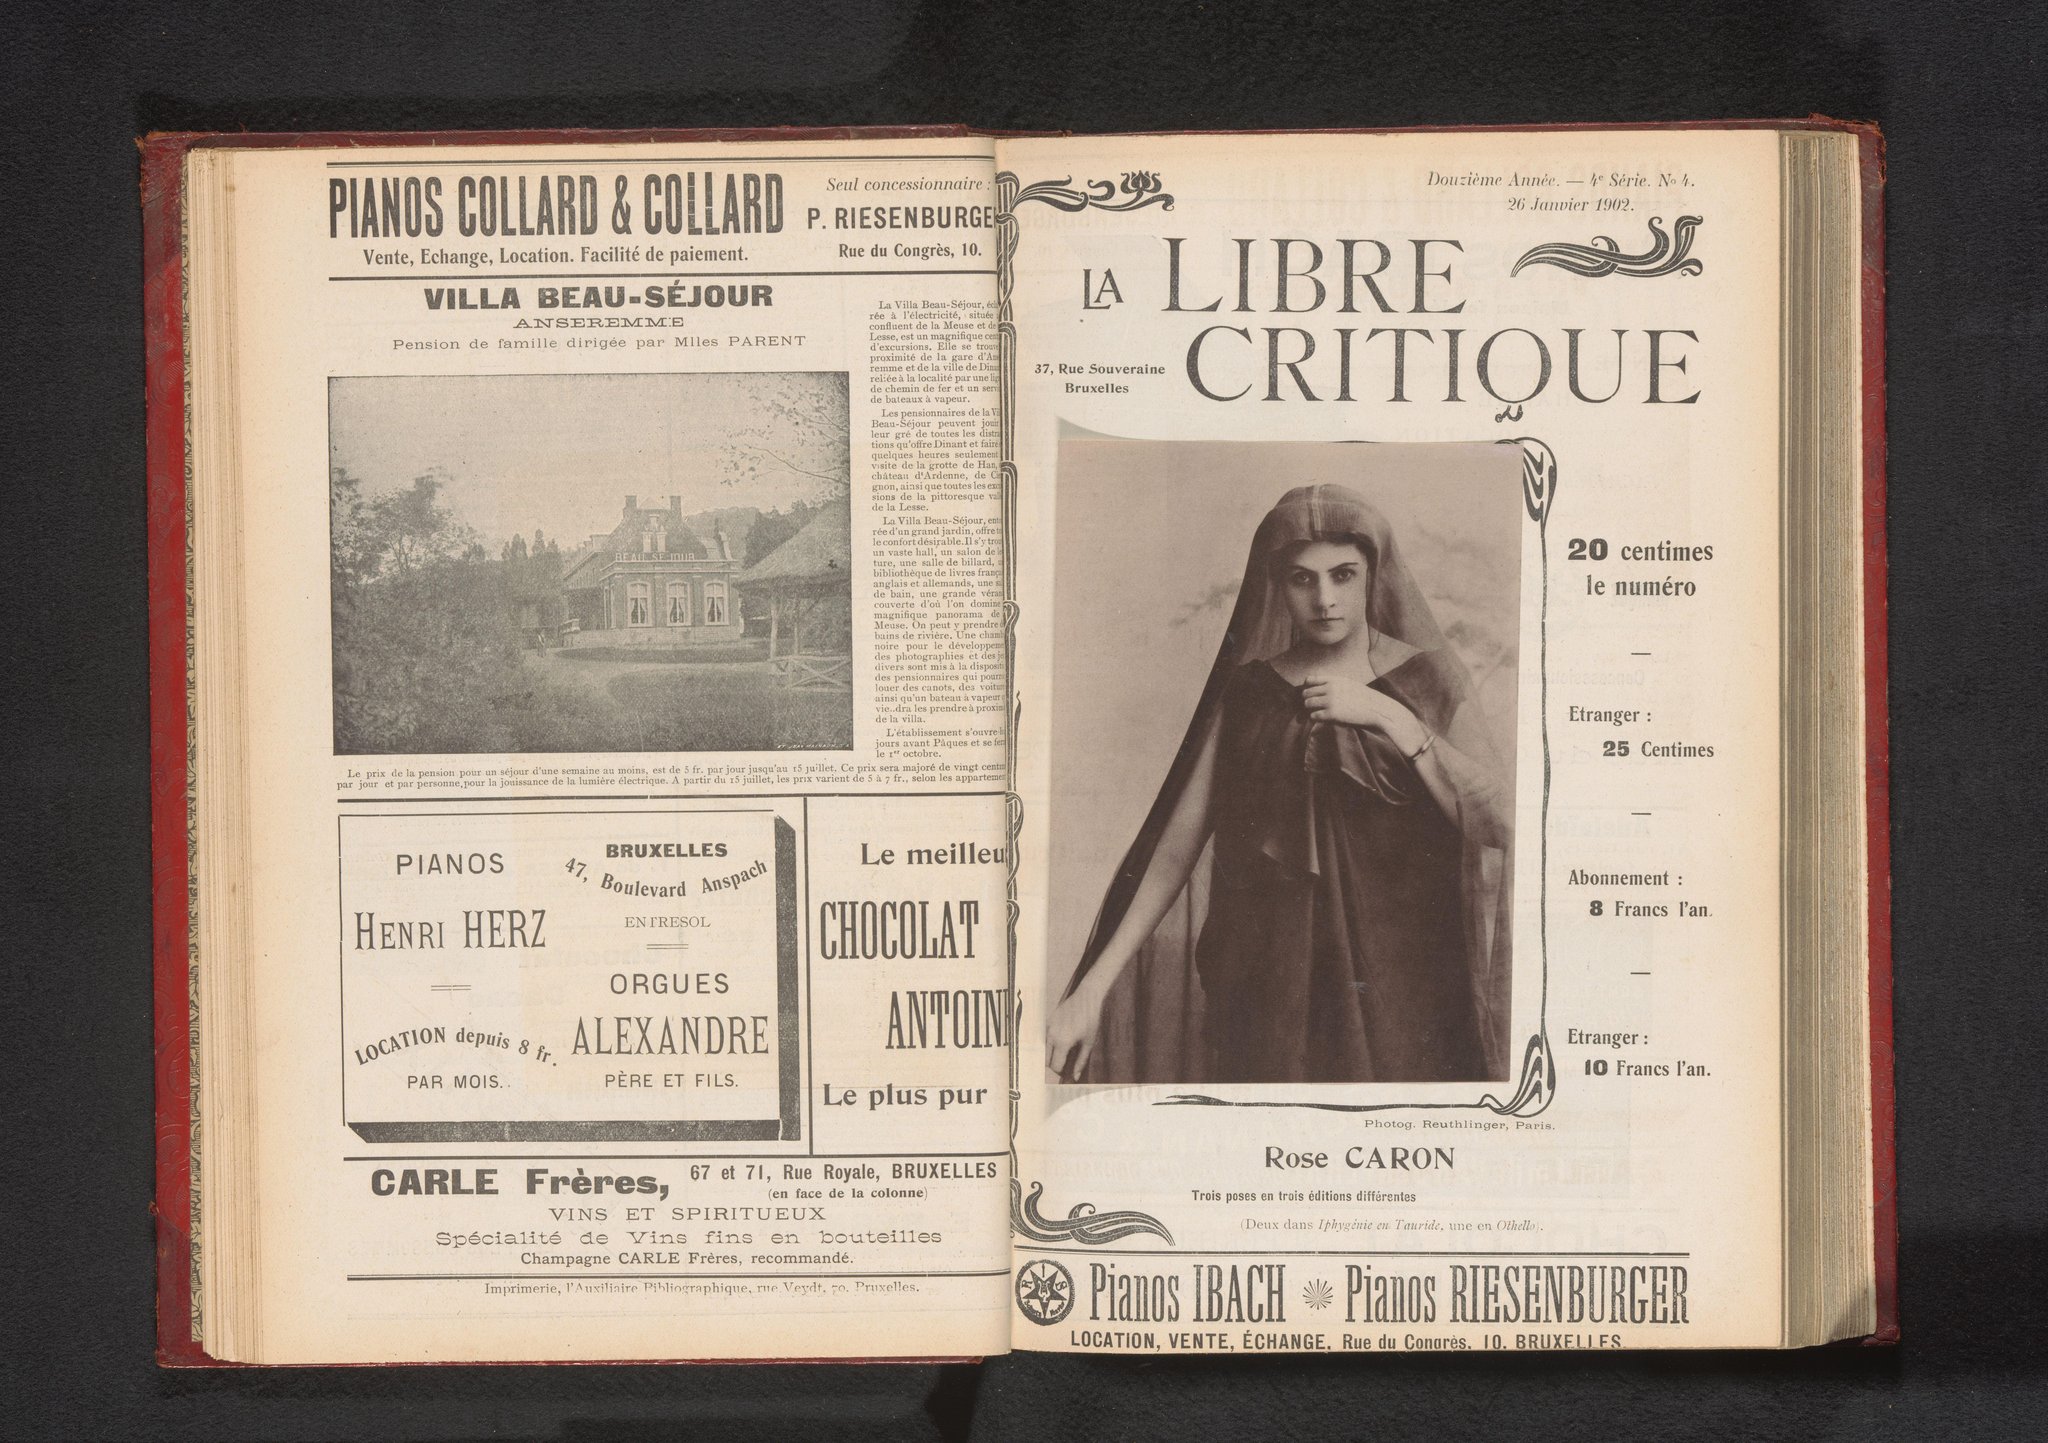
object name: page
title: Rose Caron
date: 1897-1902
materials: paper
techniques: photograph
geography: paris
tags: paris, portrait of opera-singer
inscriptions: inscription: ‘Trois poses (...) une en Othello.’